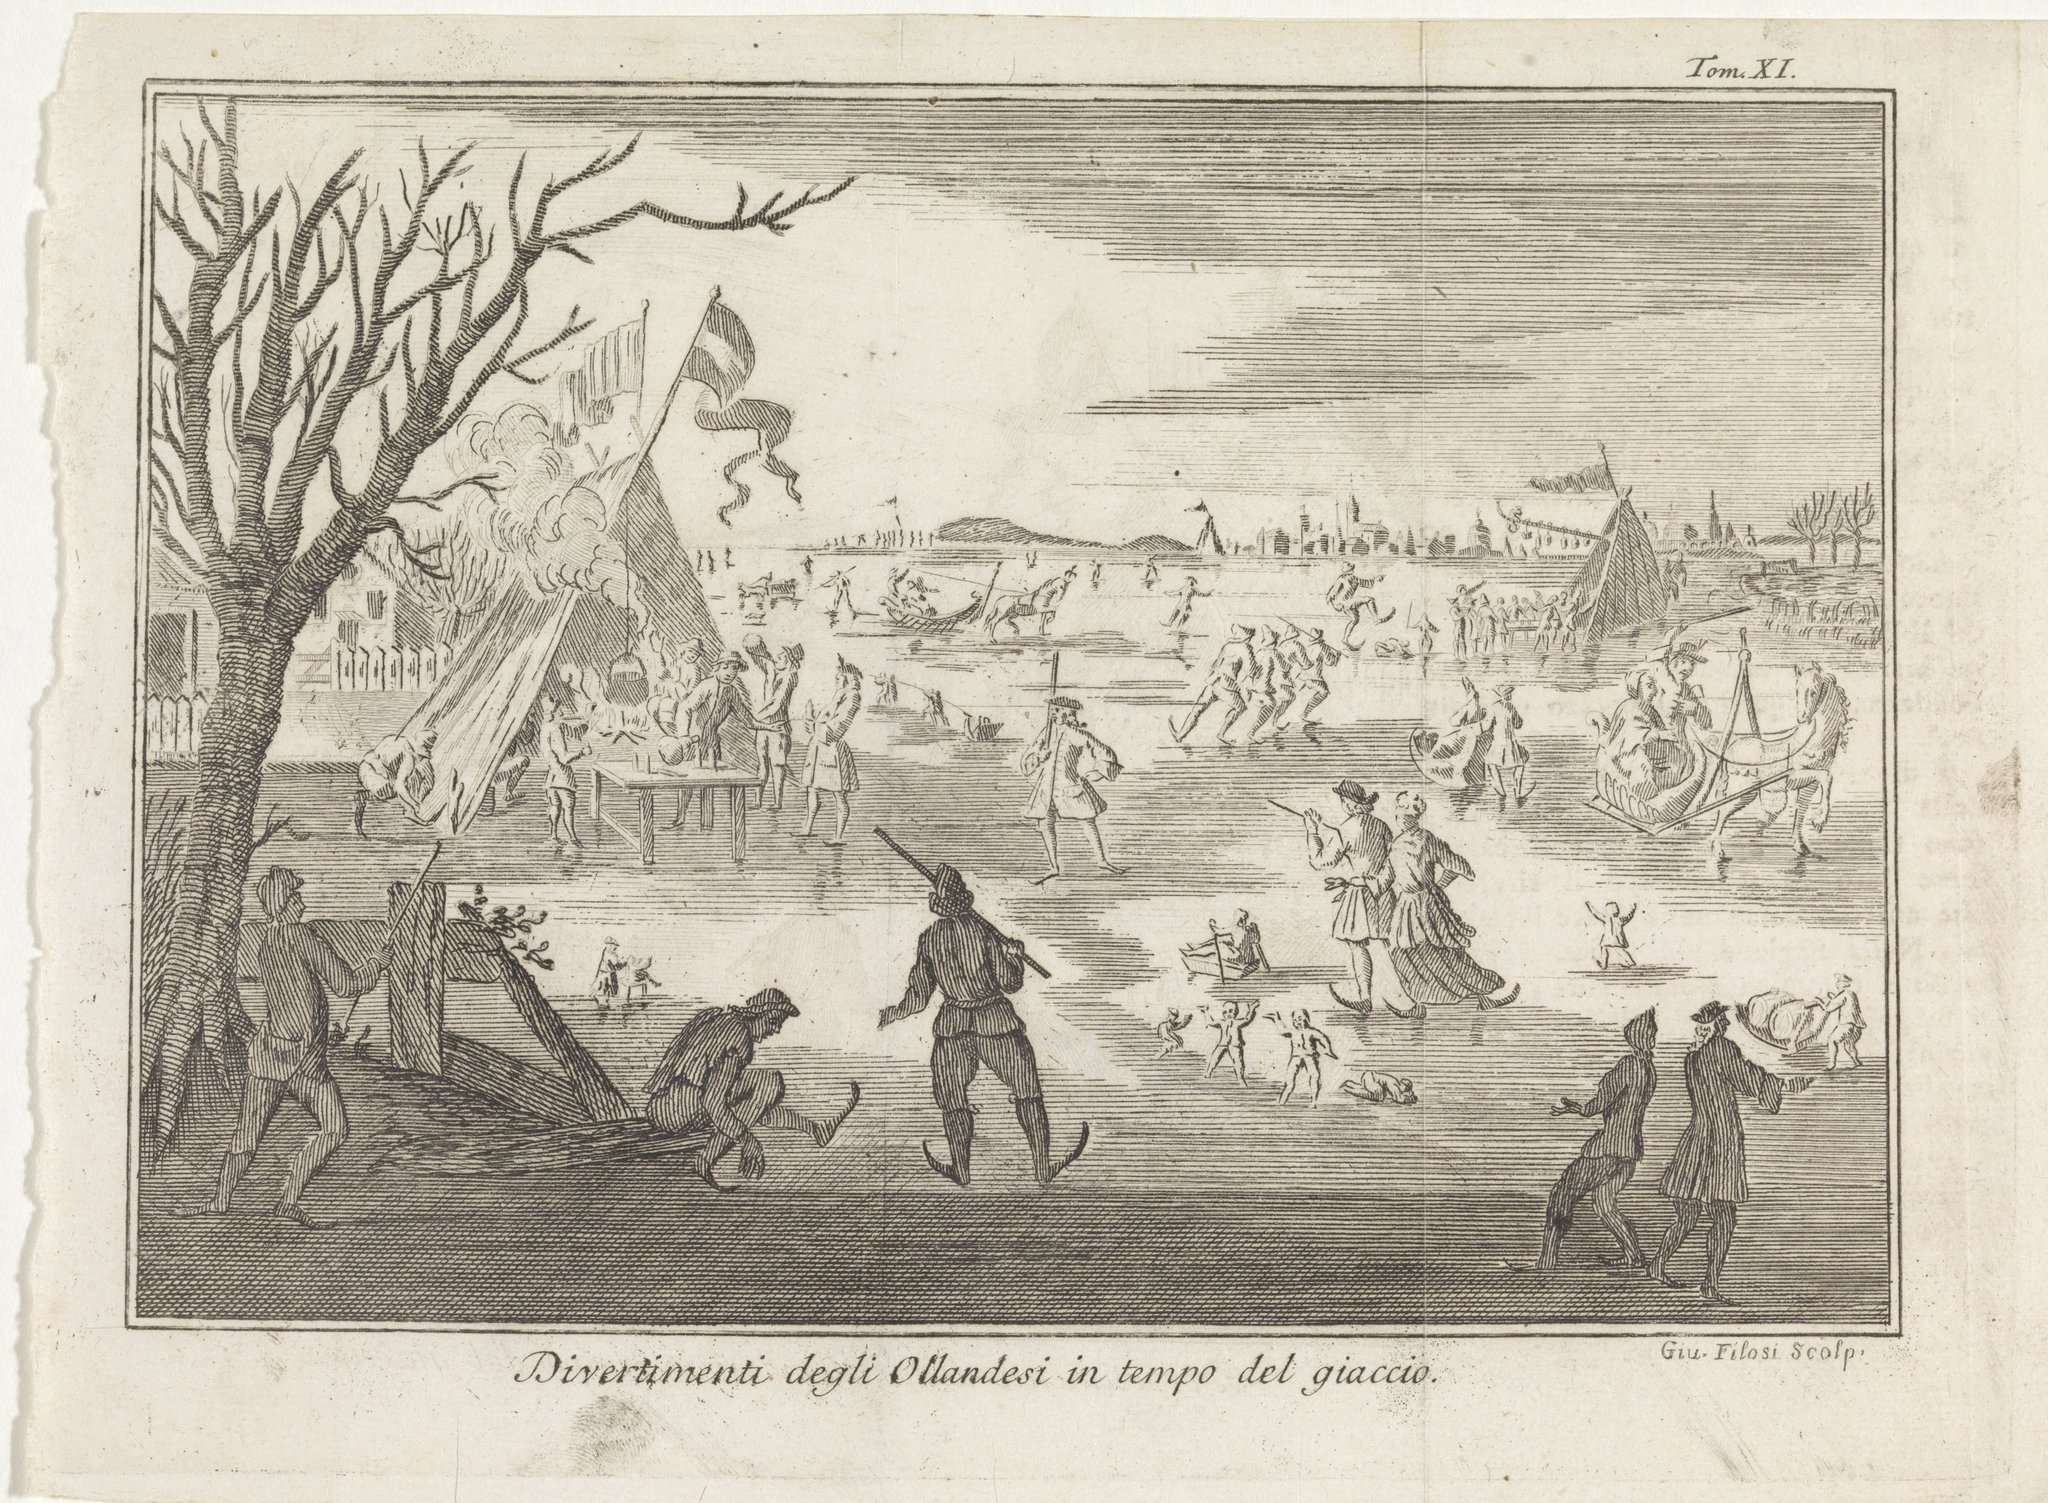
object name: print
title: Wintervermaak in Nederland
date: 1742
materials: paper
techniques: etching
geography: italy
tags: horse-sleigh, sleigh, sledge (non-sport), skates (winter sports)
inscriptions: collector's mark: Lugt 2228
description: Prent gebruikt voor Salmon, Thomas. Lo stato Presente di tutti i Paesi del Mondo... volume XI, Delle sette provincie unite, Dei paesi Bassi, Degli Svizzeri, Grigioni, e loro alleati. Venetië: Giambattista Albrizzi, 1742.